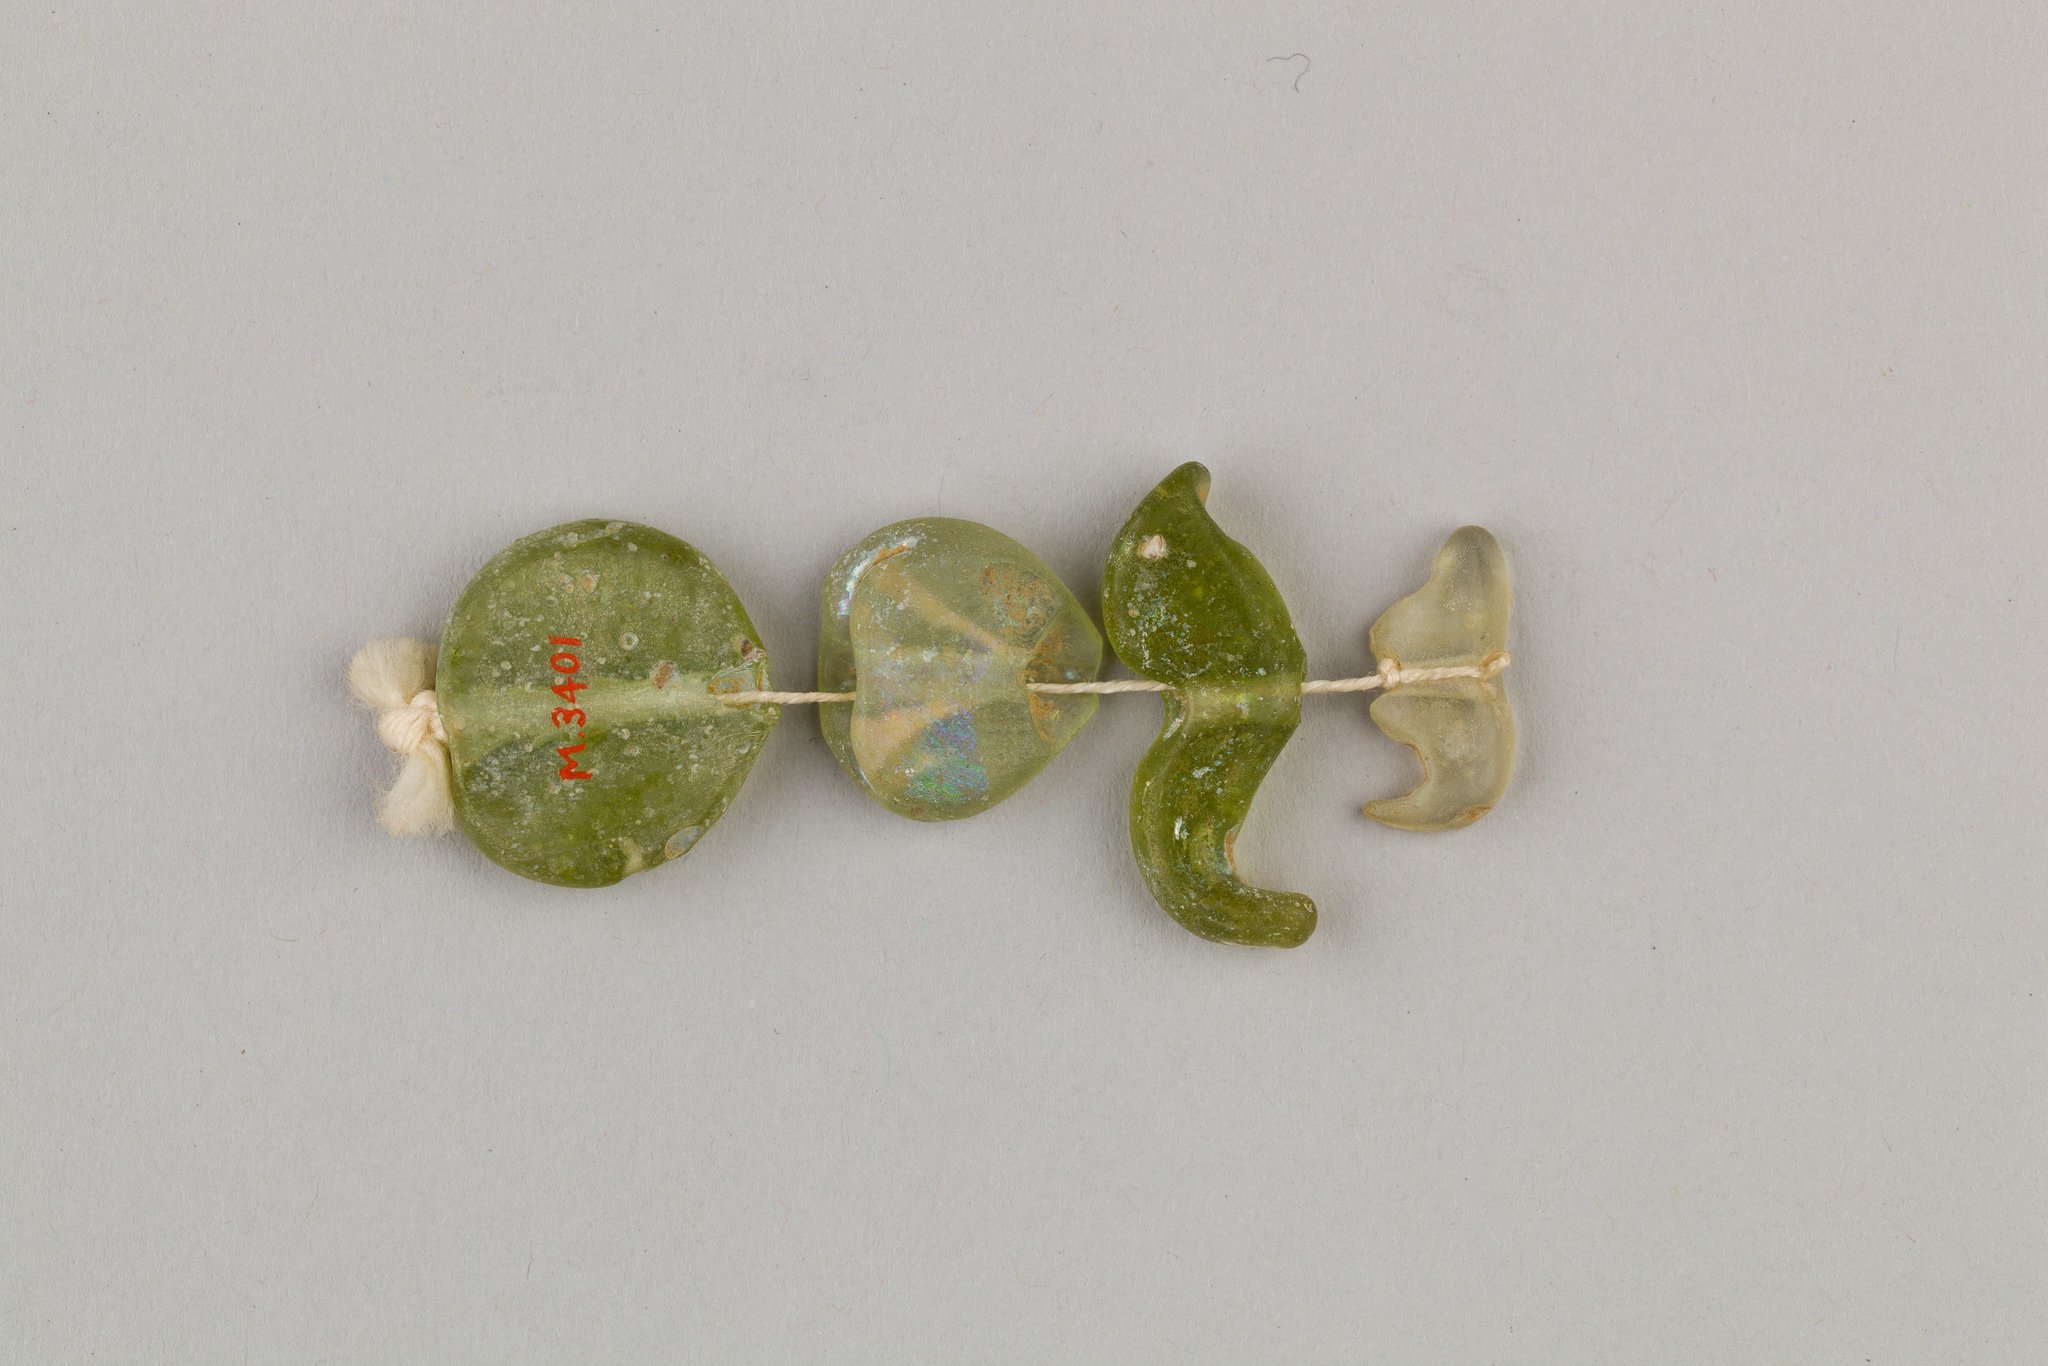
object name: bead, string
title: String of 4 beads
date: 1-366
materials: glass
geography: egypt